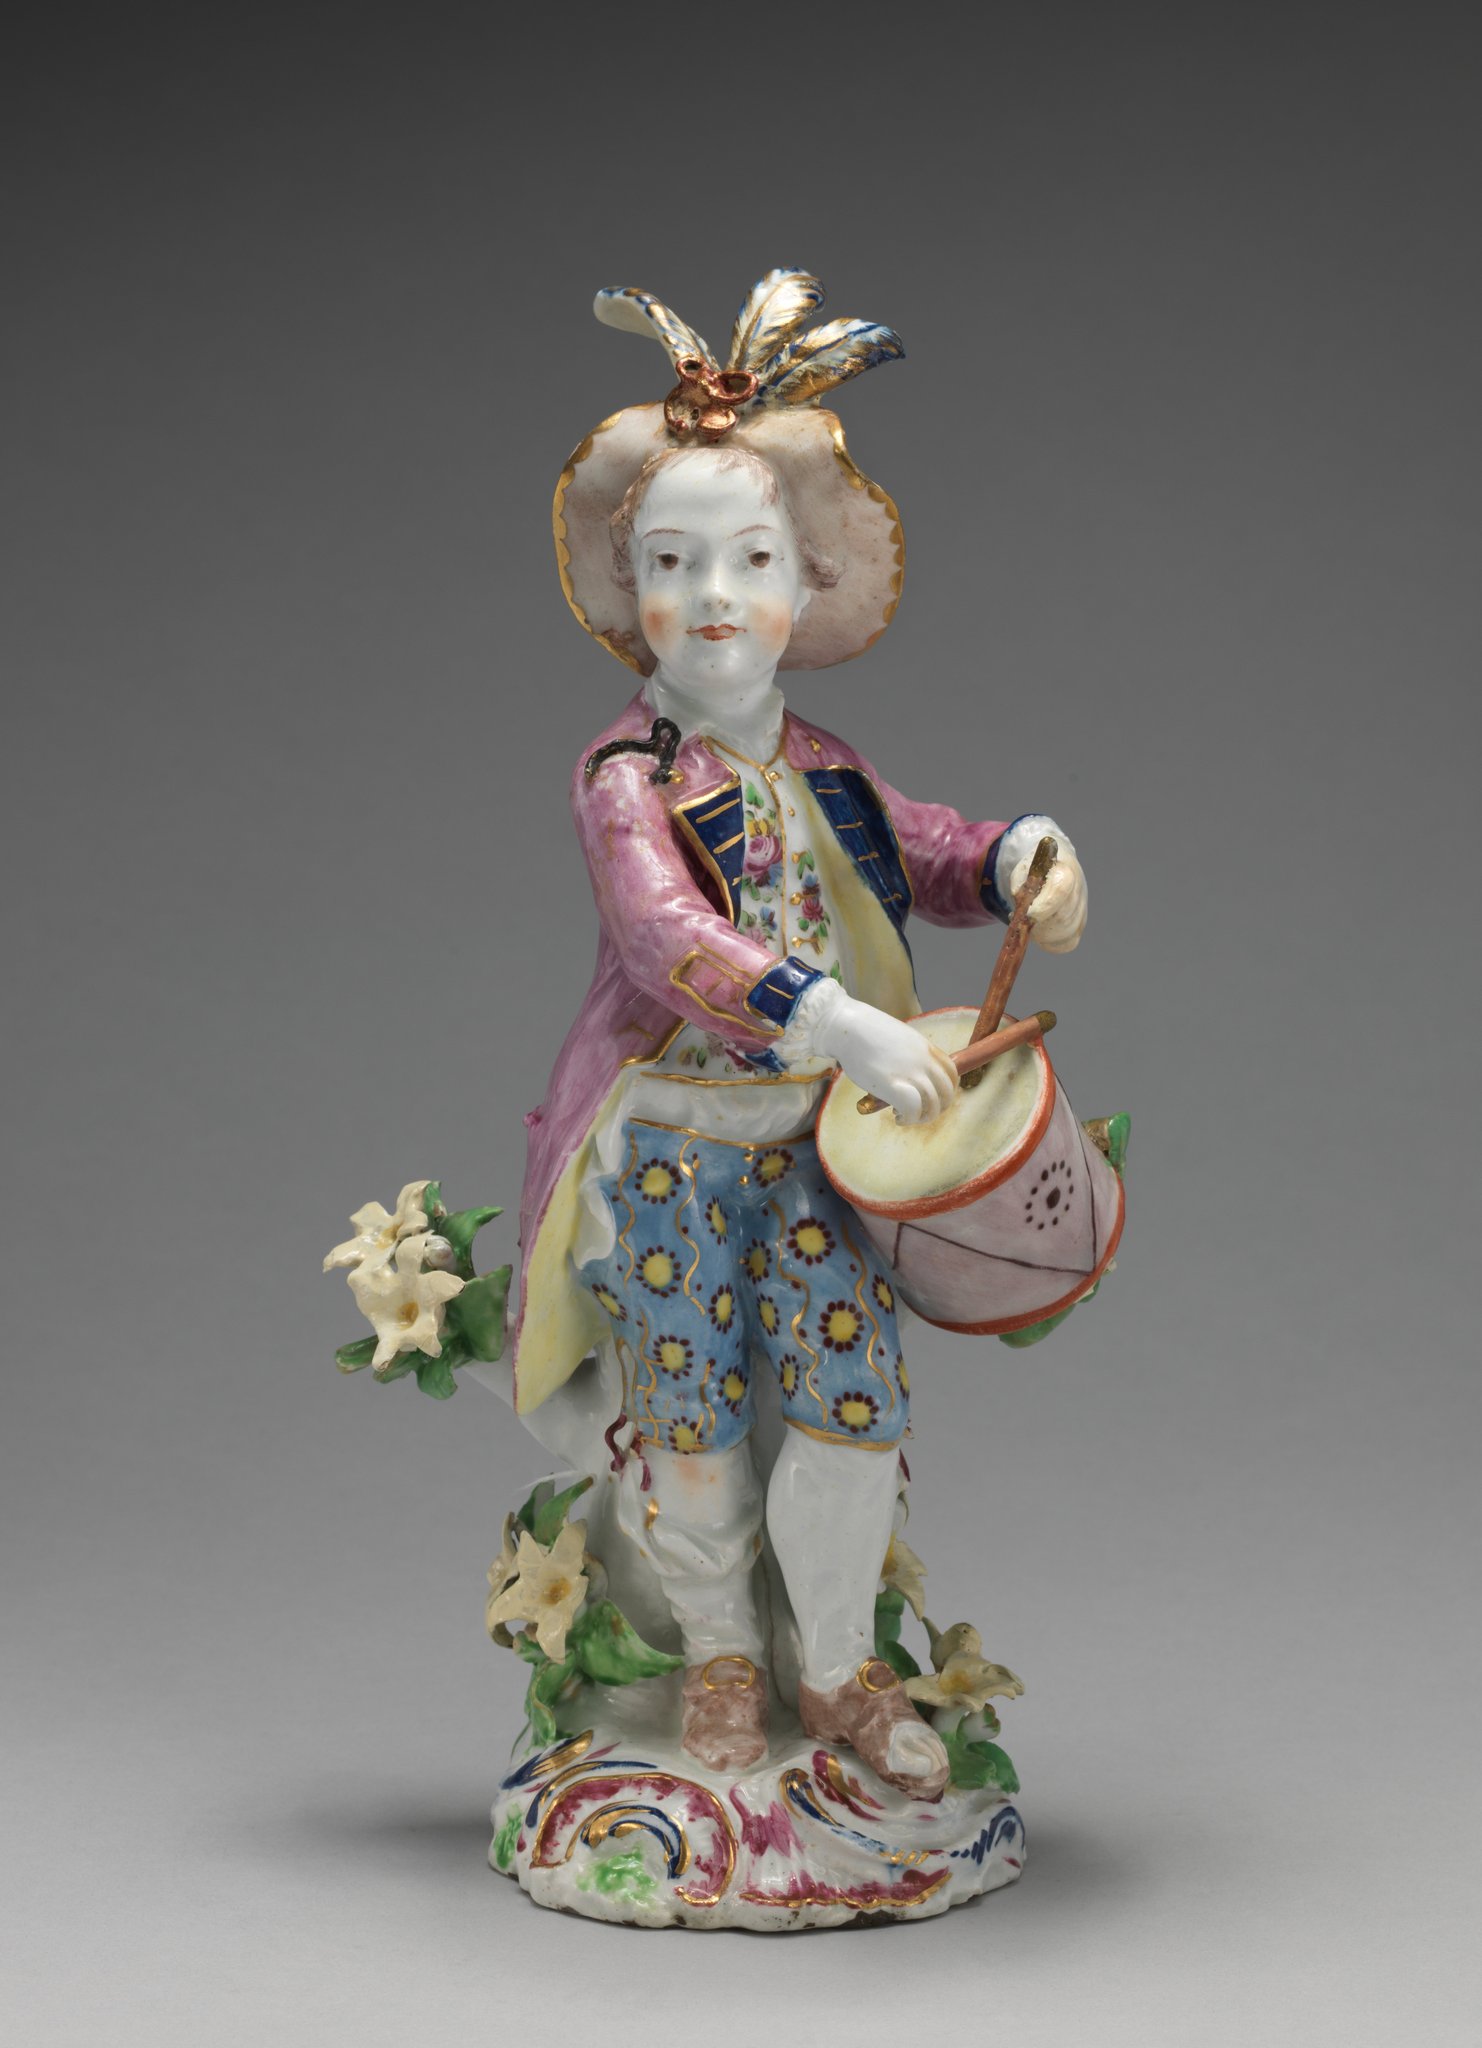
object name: figure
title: Drummer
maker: bow porcelain factory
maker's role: factory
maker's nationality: british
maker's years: 1747-1776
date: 1765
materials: soft paste porcelain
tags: men,drums,musicians